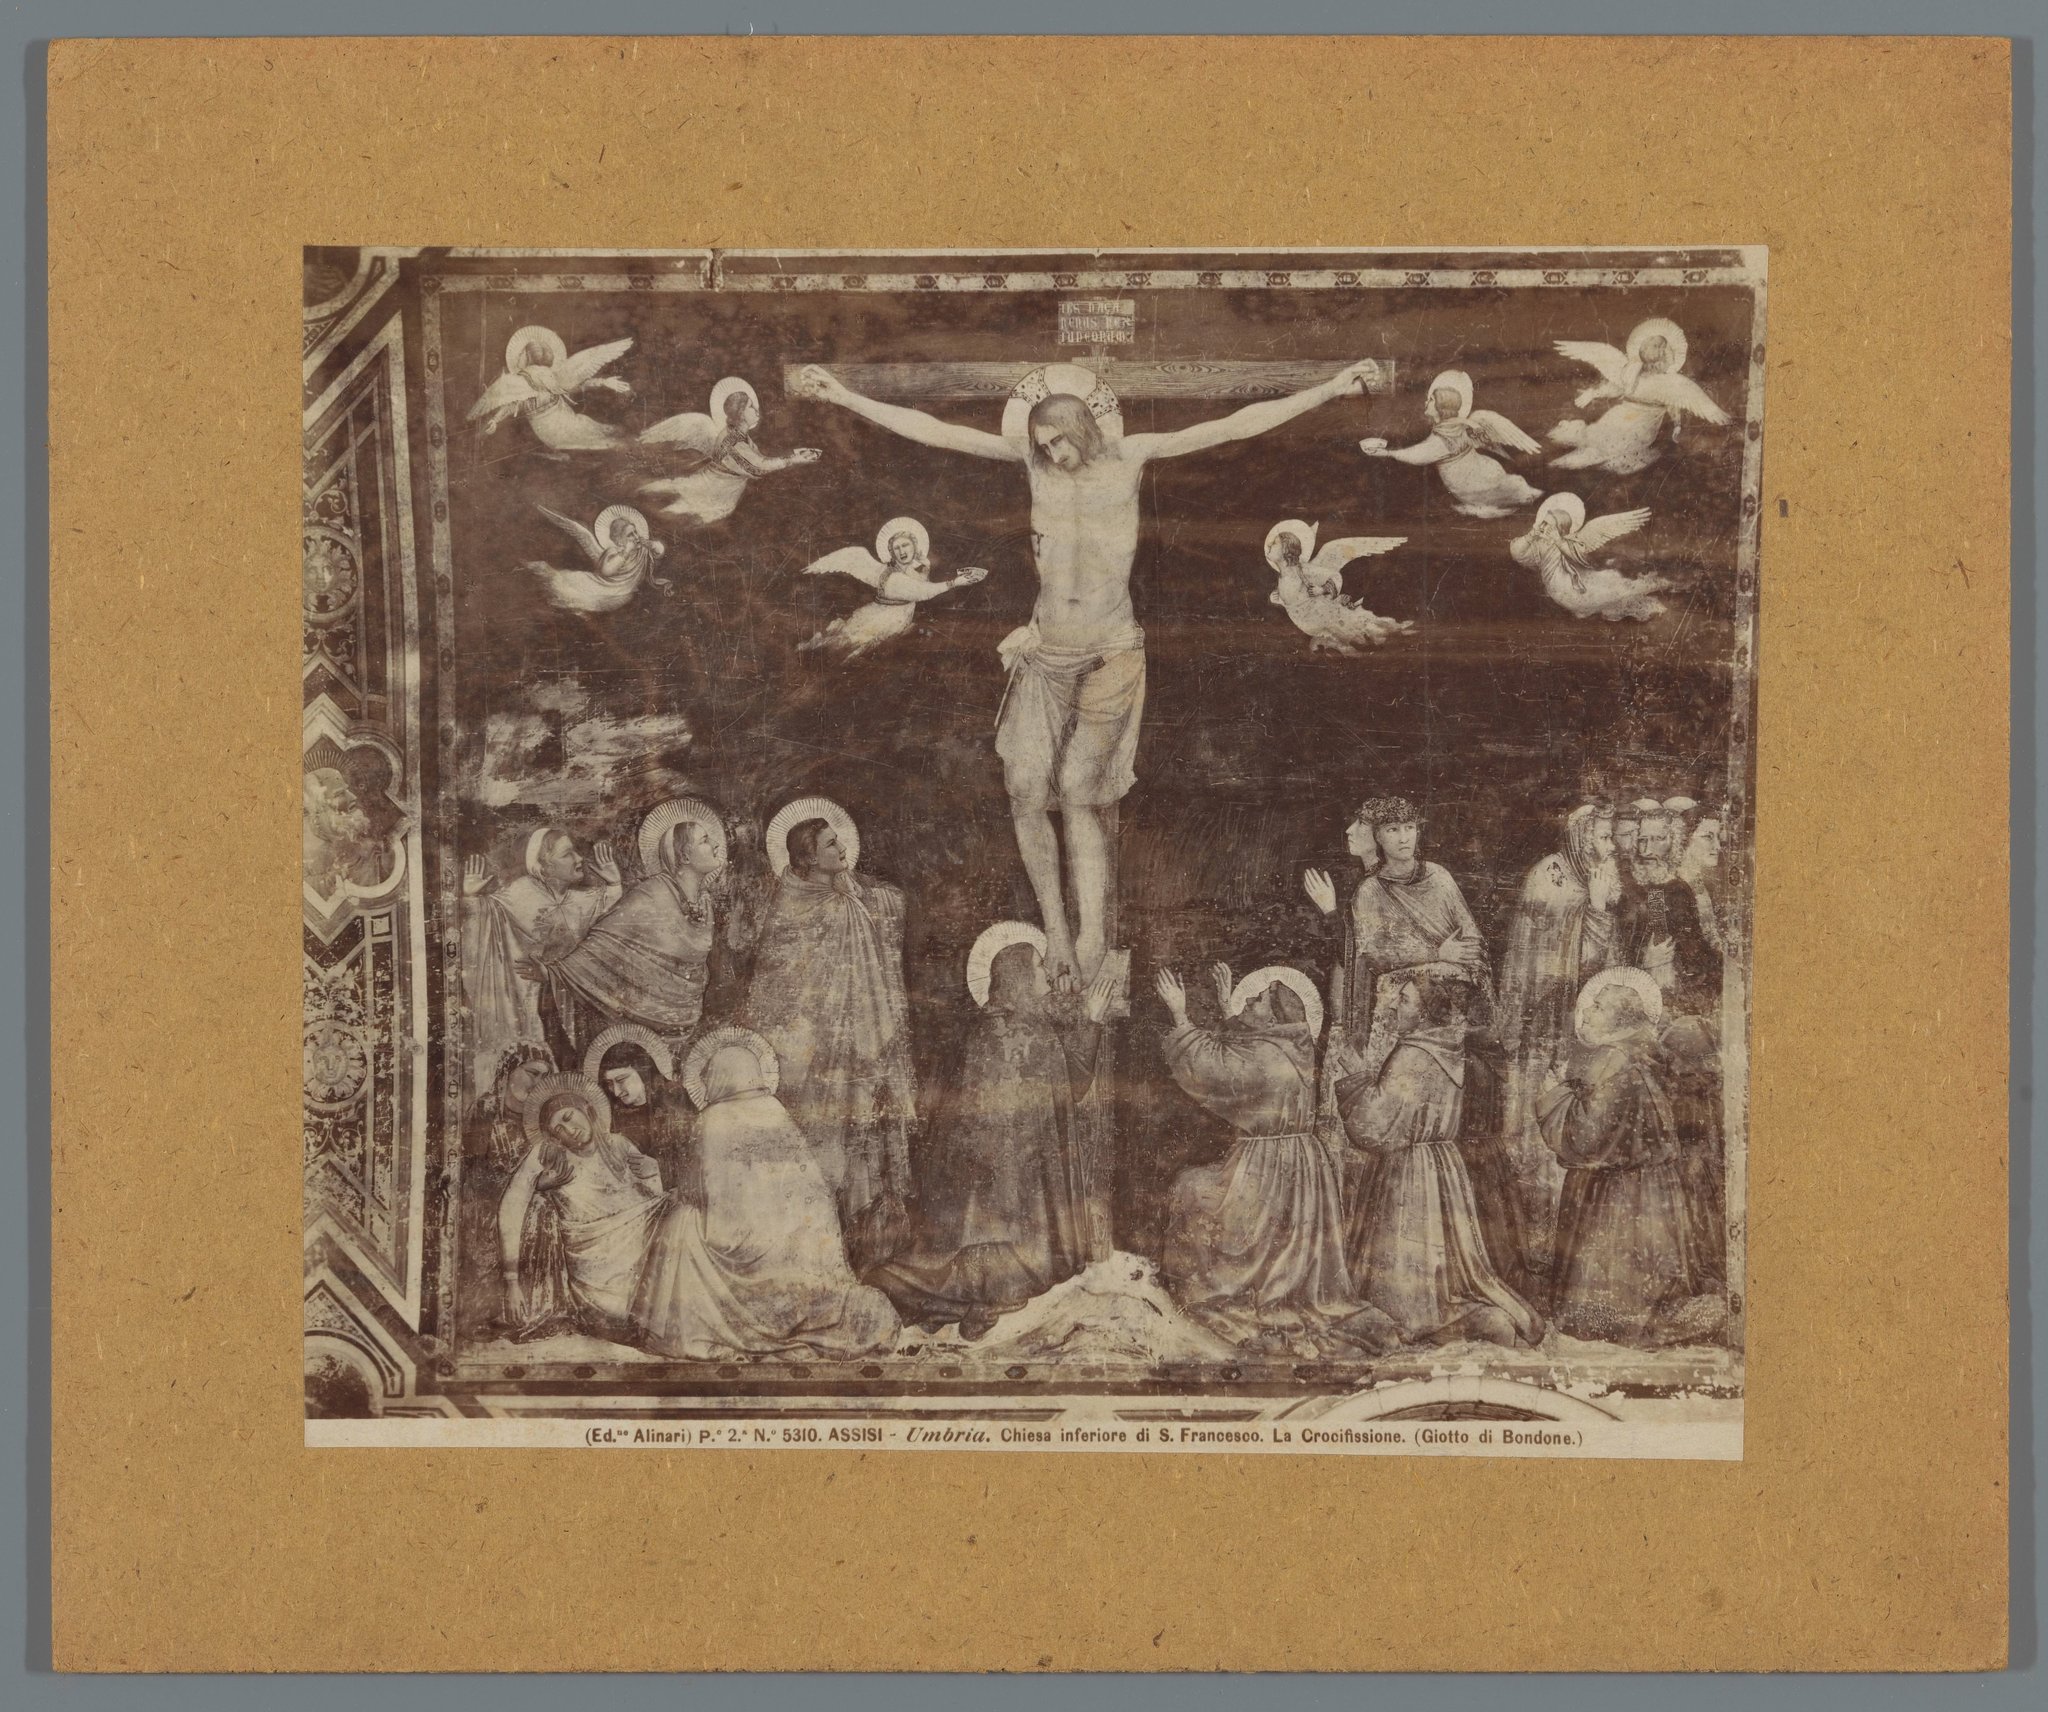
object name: reproduction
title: ASSISI - Umbria. Chiesa inferiore di S. Francesco. La Crocifissione.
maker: giotto de bondone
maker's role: painter, sculptor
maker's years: 1266-1337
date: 1875-1900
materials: cardboard, photographic support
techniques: albumen print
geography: sint-franciscusbasiliek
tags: angels, the crucifixion of christ: christ's death on the cross; golgotha (matthew 27:45-58; mark 15:33-45; luke 23:44-52; john 19:25-38)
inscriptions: number: ‘P.e 2.a N.o 5310.’, collector's mark: Lugt 3937